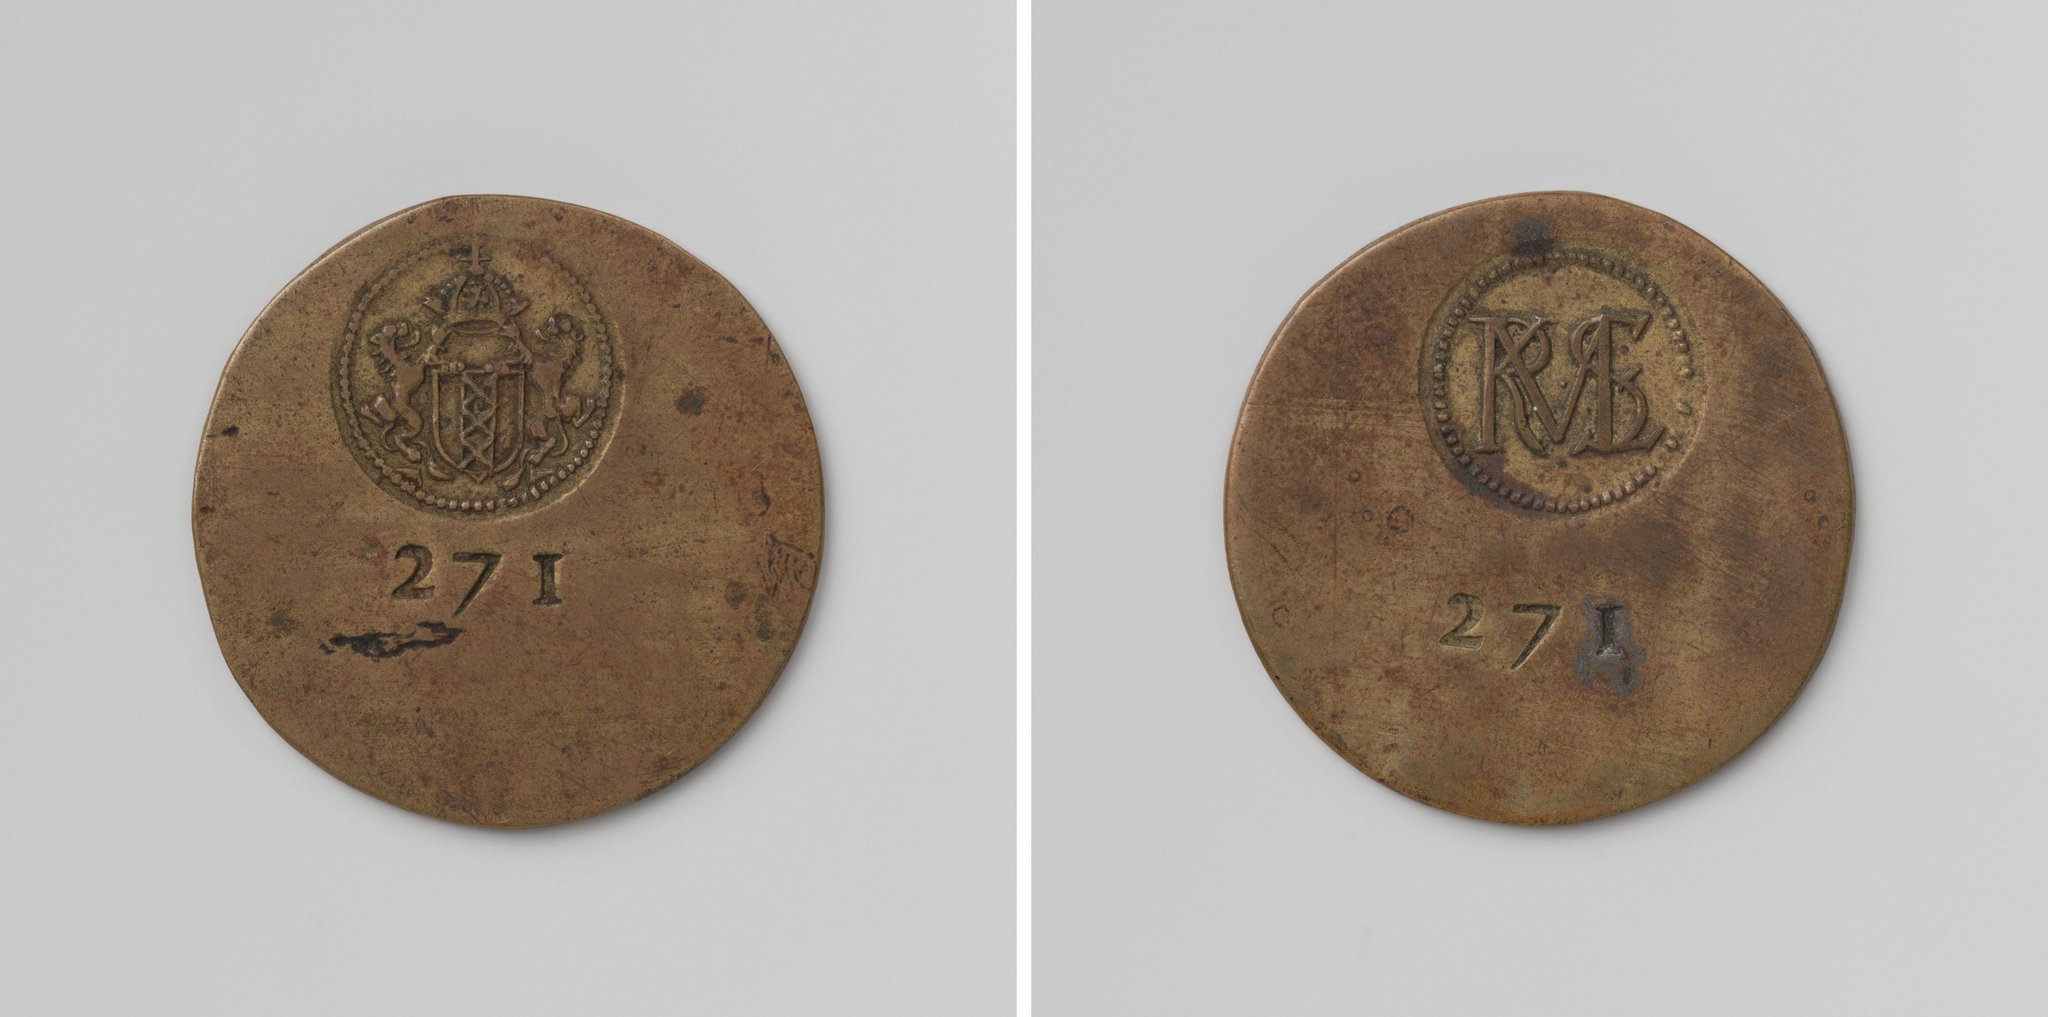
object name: medal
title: Makelaarsgilde van Amsterdam, begrafenispenning met no. 271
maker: Anonymous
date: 1700-1800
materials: brass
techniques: striking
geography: amsterdam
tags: amsterdam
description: Messing penning. Voorzijde: gekroond wapenschild, geflankeerd door twee leeuwen in ronde parelrand boven cijfer 271. Keerzijde: monogram van letters M, K, R en S binnen ronde parelrand boven cijfer 271